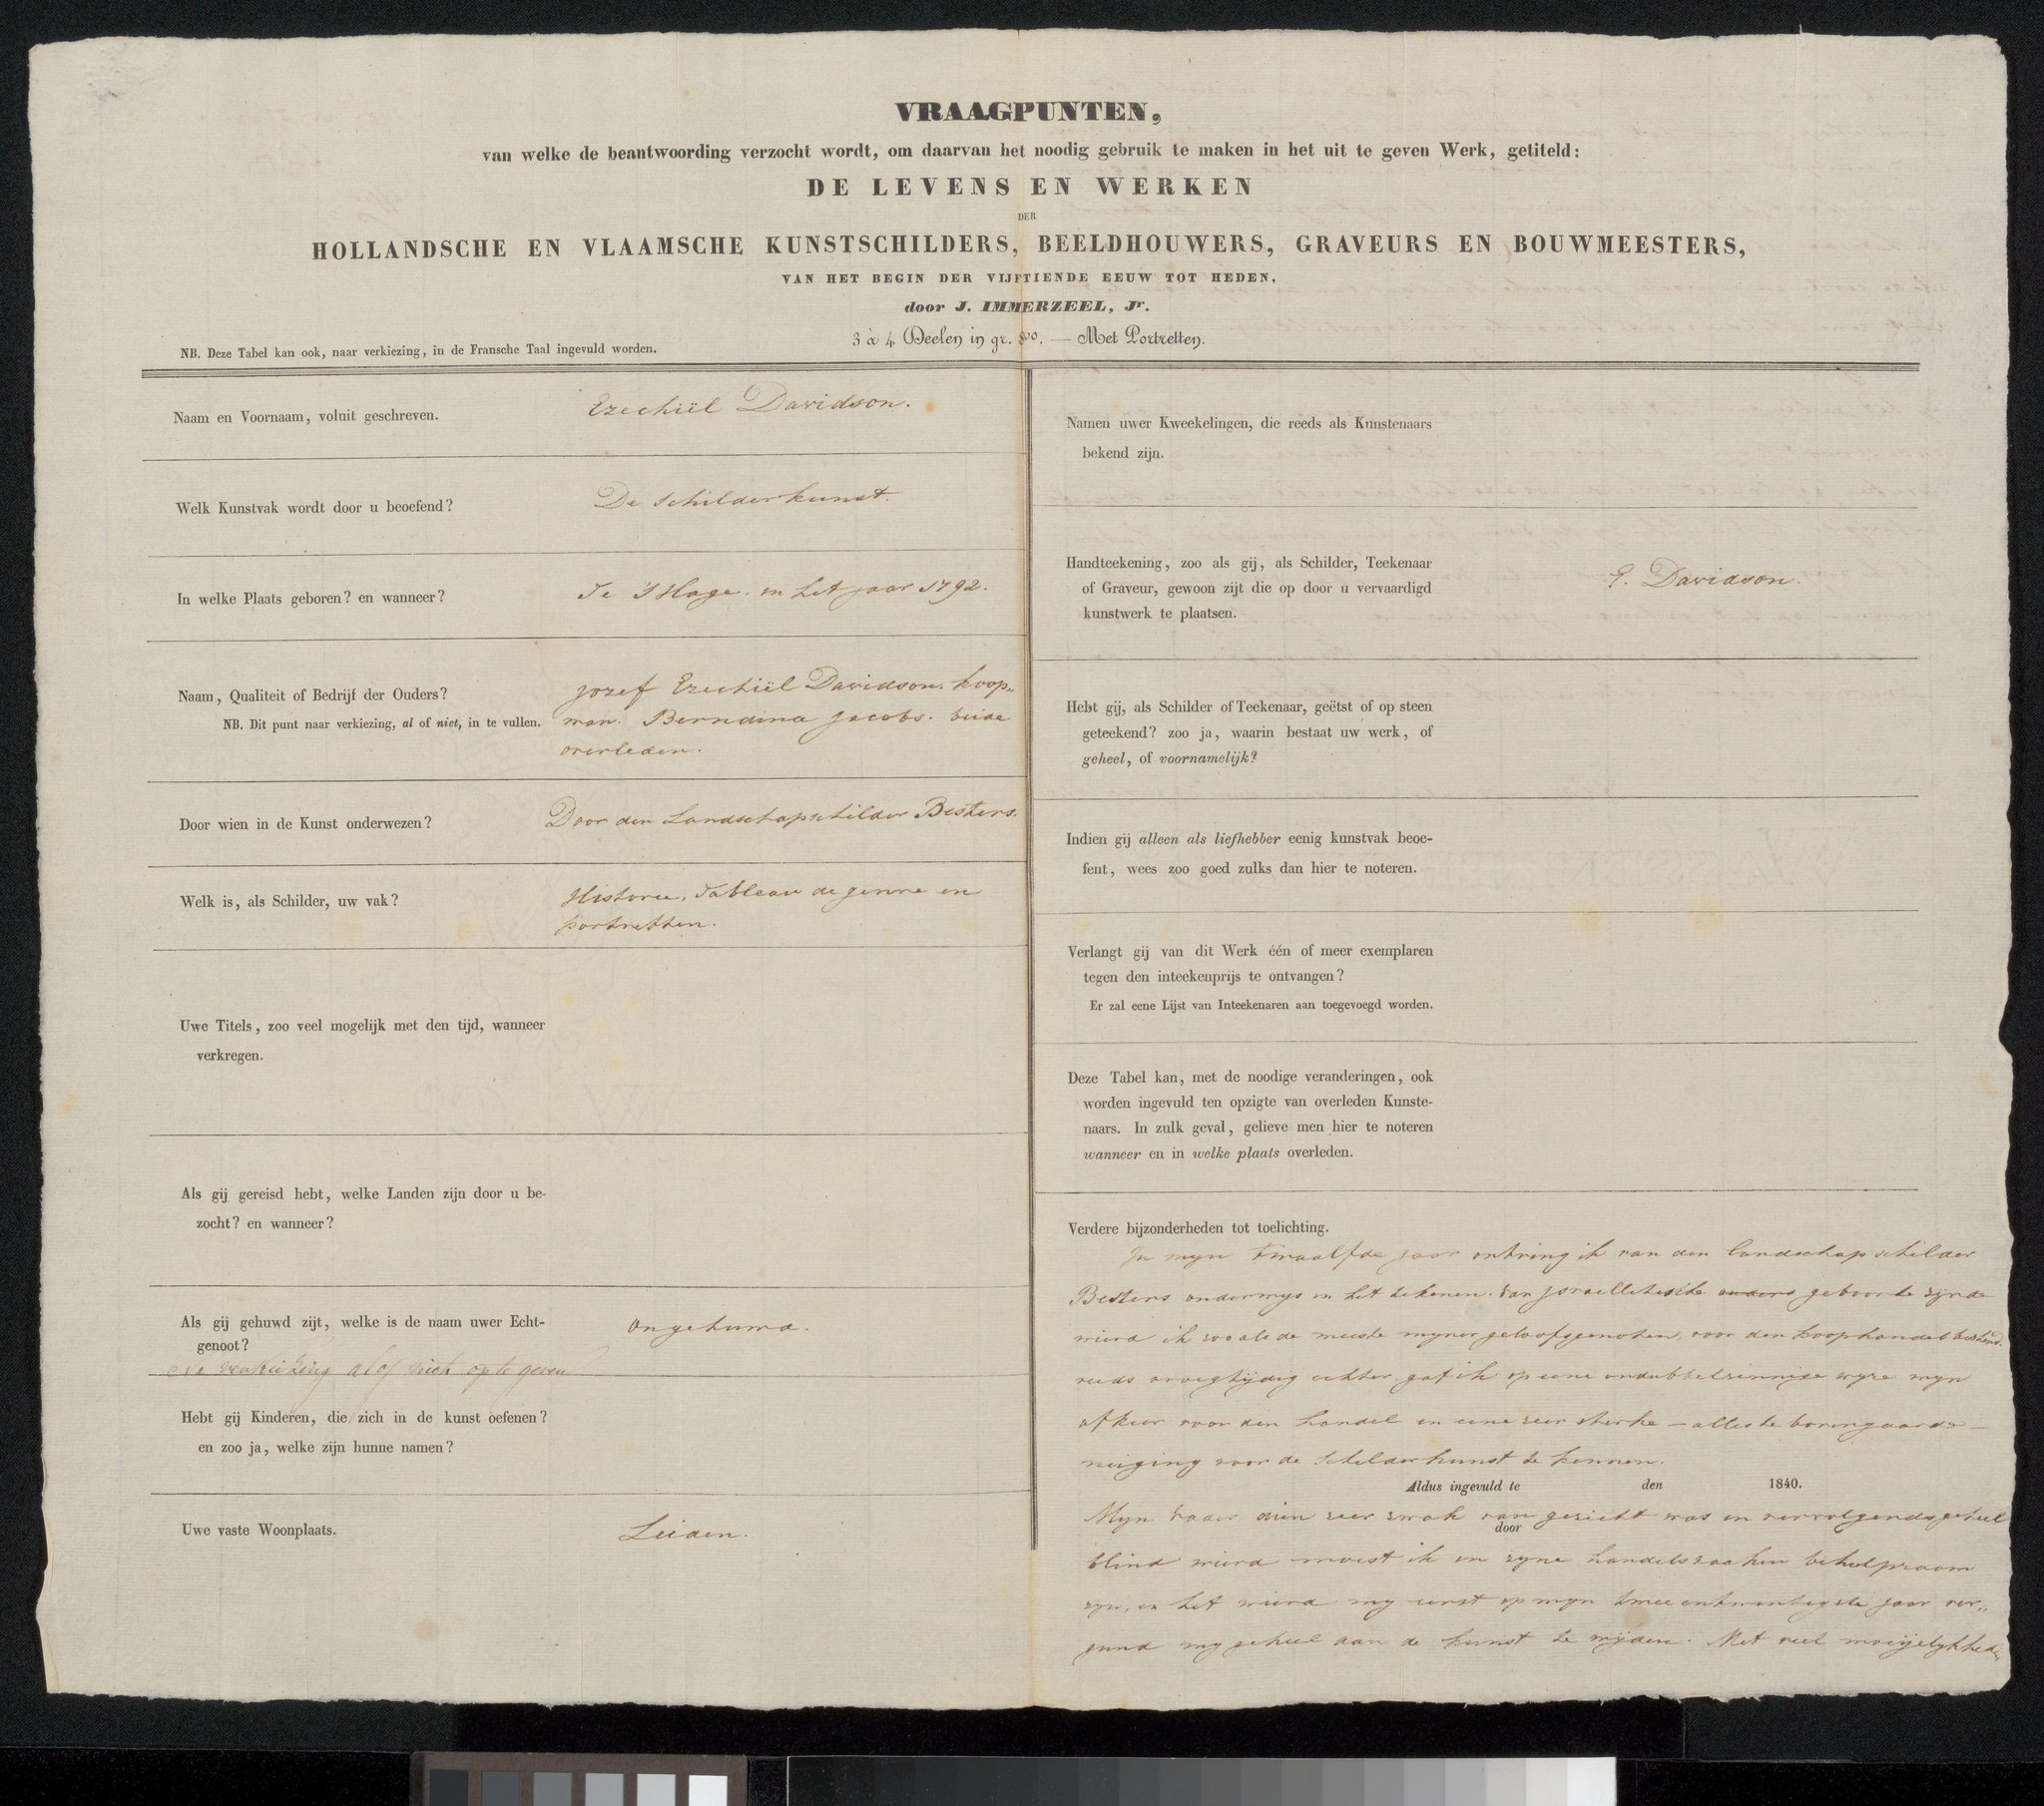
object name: manuscript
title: Enquêteformulier ingevuld door Ezechiel Davidson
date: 1840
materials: ink, paper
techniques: pen, printing, writing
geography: leiden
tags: leiden, ezechiel davidson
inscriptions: inscription: ‘Vraagpunten,/ van welke de beantwoording verzocht wordt, om daarvan het noodig gebruik te maken in het uit te geven Werk, getiteld: De levens en werken/ der Hollandsche en Vlaamsche kunstschilders, beeldhouwers,/ graveurs en bouwmeesters, van het begin der vijftiende eeuw tot heden/ door J. Immerzeel, Jr.’, watermark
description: Opgenomen in: Immerzeel, J. Jr., De levens en werken der Hollandsche en Vlaamsche kunstschilders, beeldhouwers, graveurs en bouwmeesters, van het begin der vijftiende eeuw tot heden, Amsterdam: J.C. van Kesteren, 1842-1843.